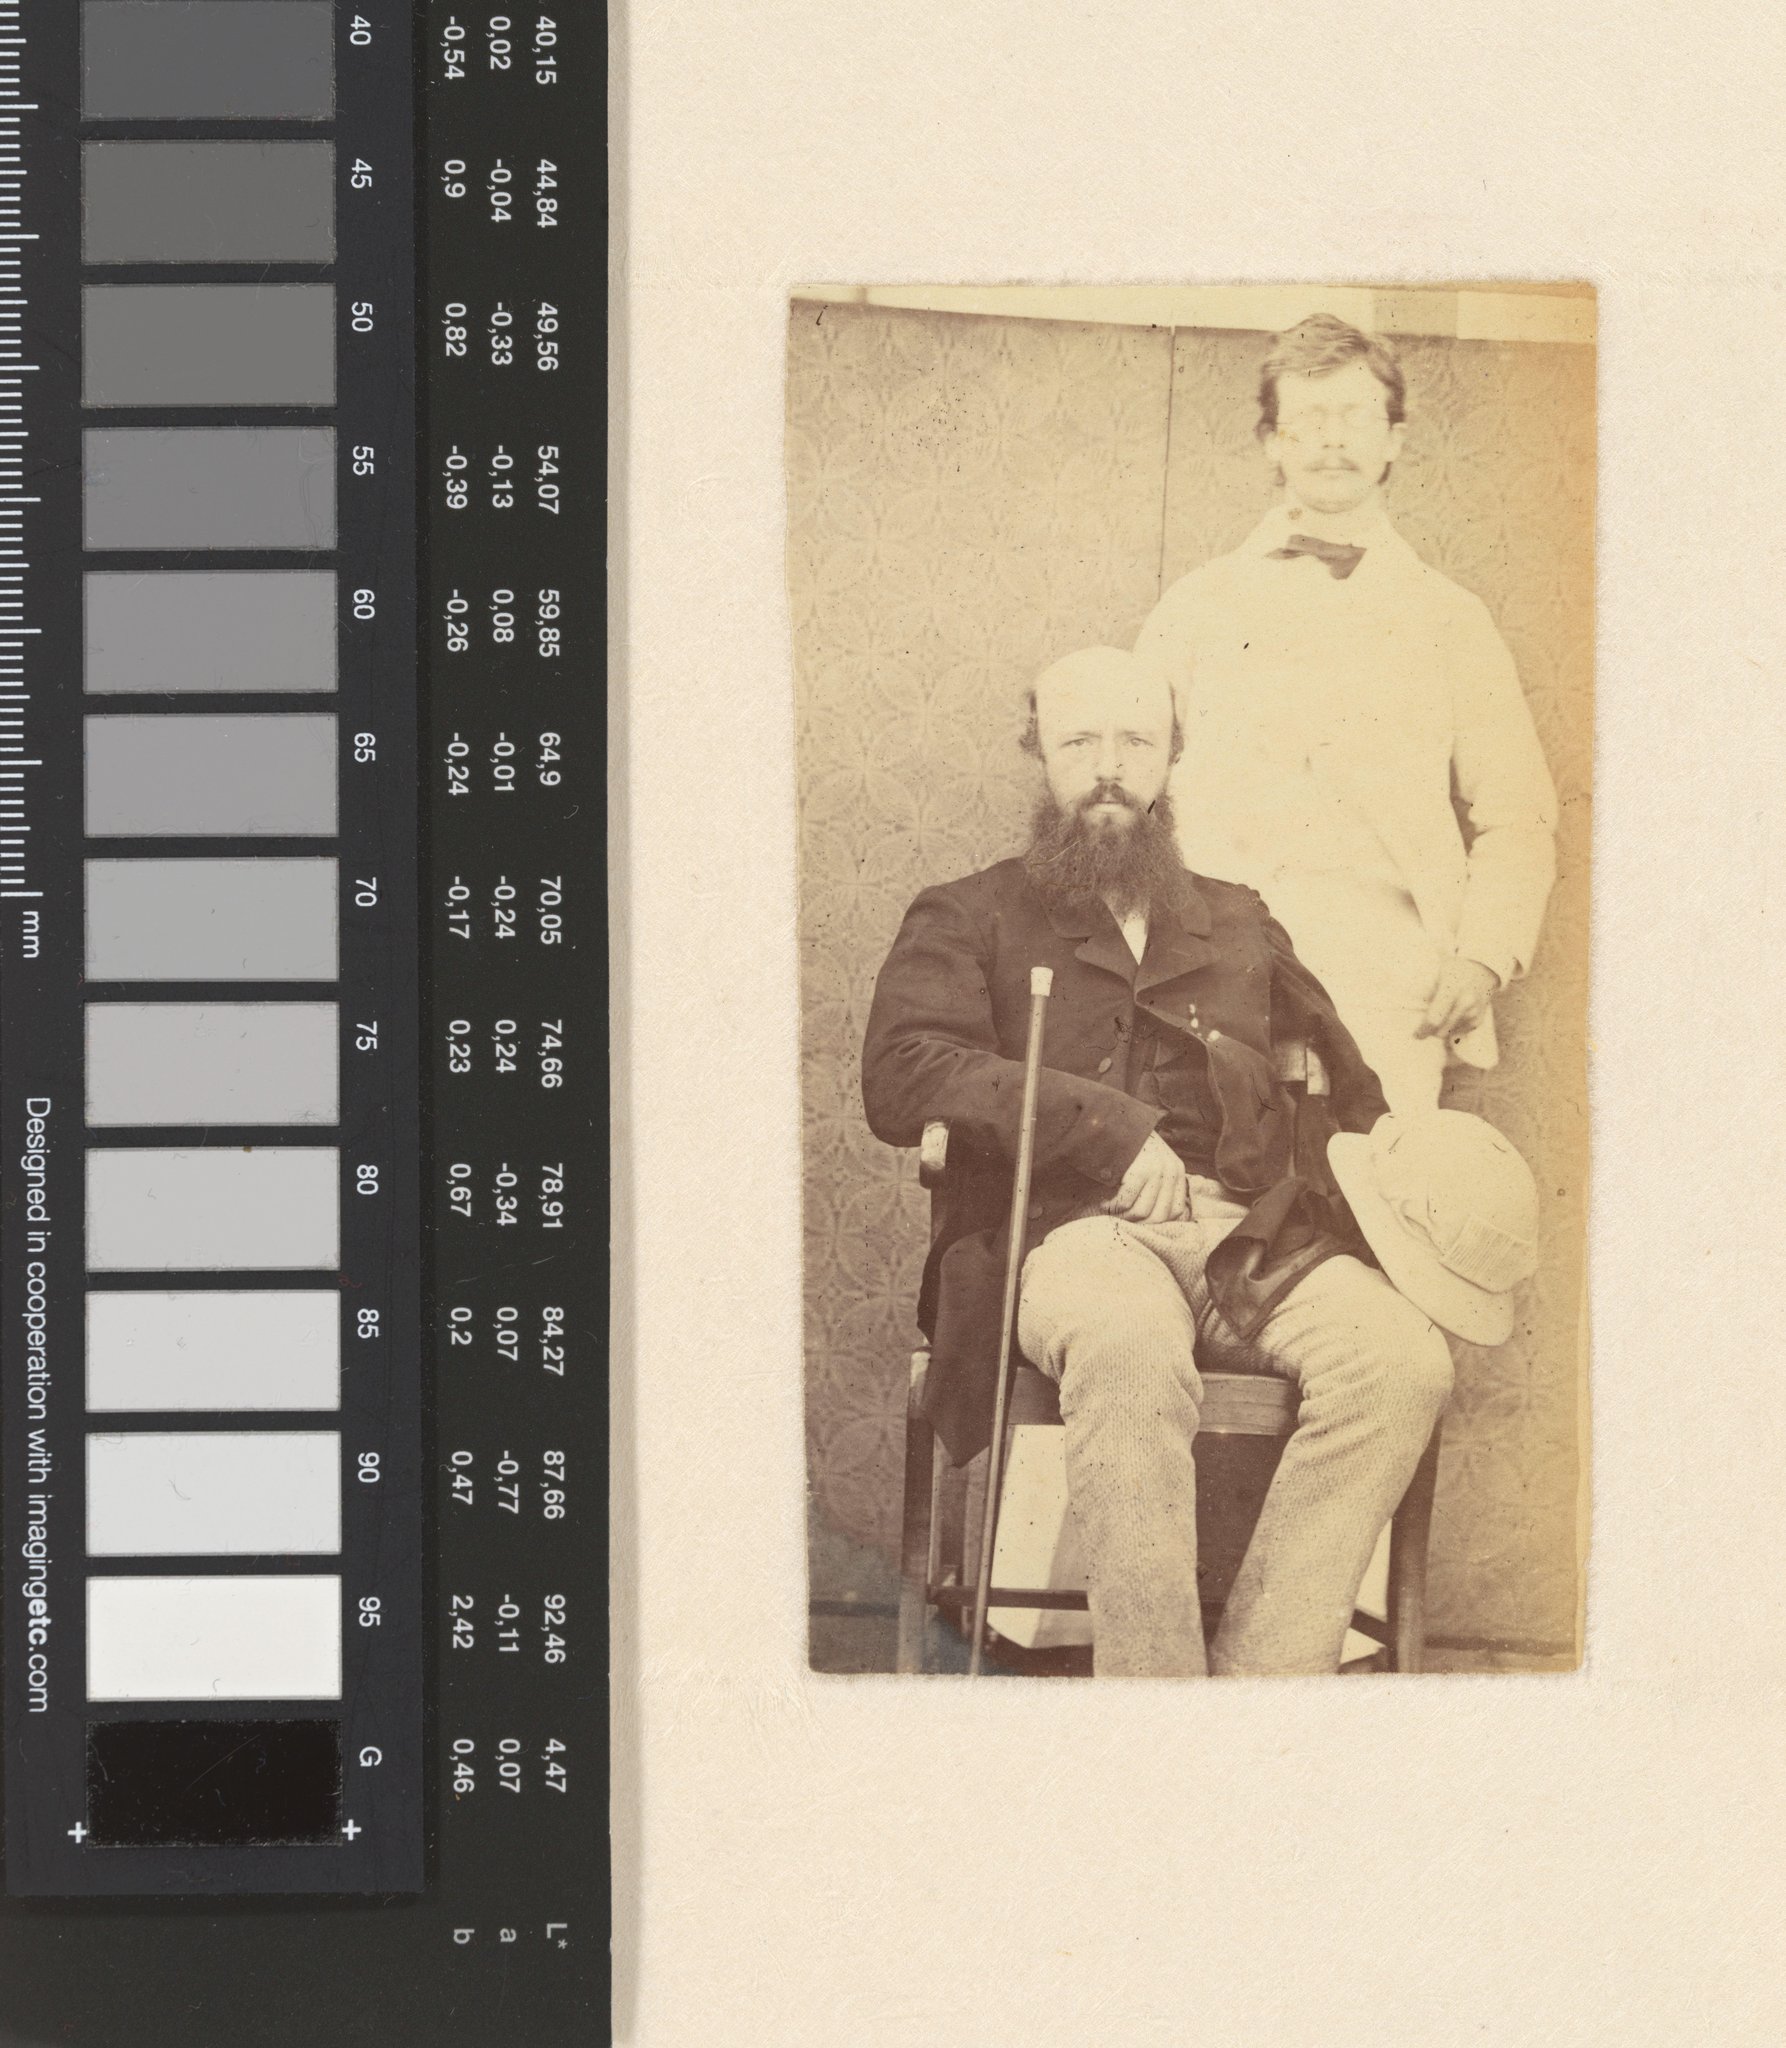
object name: photograph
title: Albert Bauduin (left) and Theodorus Kroes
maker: antoon bauduin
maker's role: amateurfotograaf, hoogleraar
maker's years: 1820-1885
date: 1862-1866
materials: paper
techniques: albumen print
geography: japan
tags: dordrecht, the hague, antoon bauduin, historical persons (portraits and scenes from the life), japan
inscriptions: number: ‘79’, number: ‘BD 84’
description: Among the few people we can identify in these photos is Theodorus Kroes (1822-1889). Born in Dordrecht, like the Bauduins, the men were good friends and occasionally visited each other. As an agent of the Nederlandse Handel-Maatschappij in the Chinese port city of Shanghai, Kroes and Albert were also colleagues.